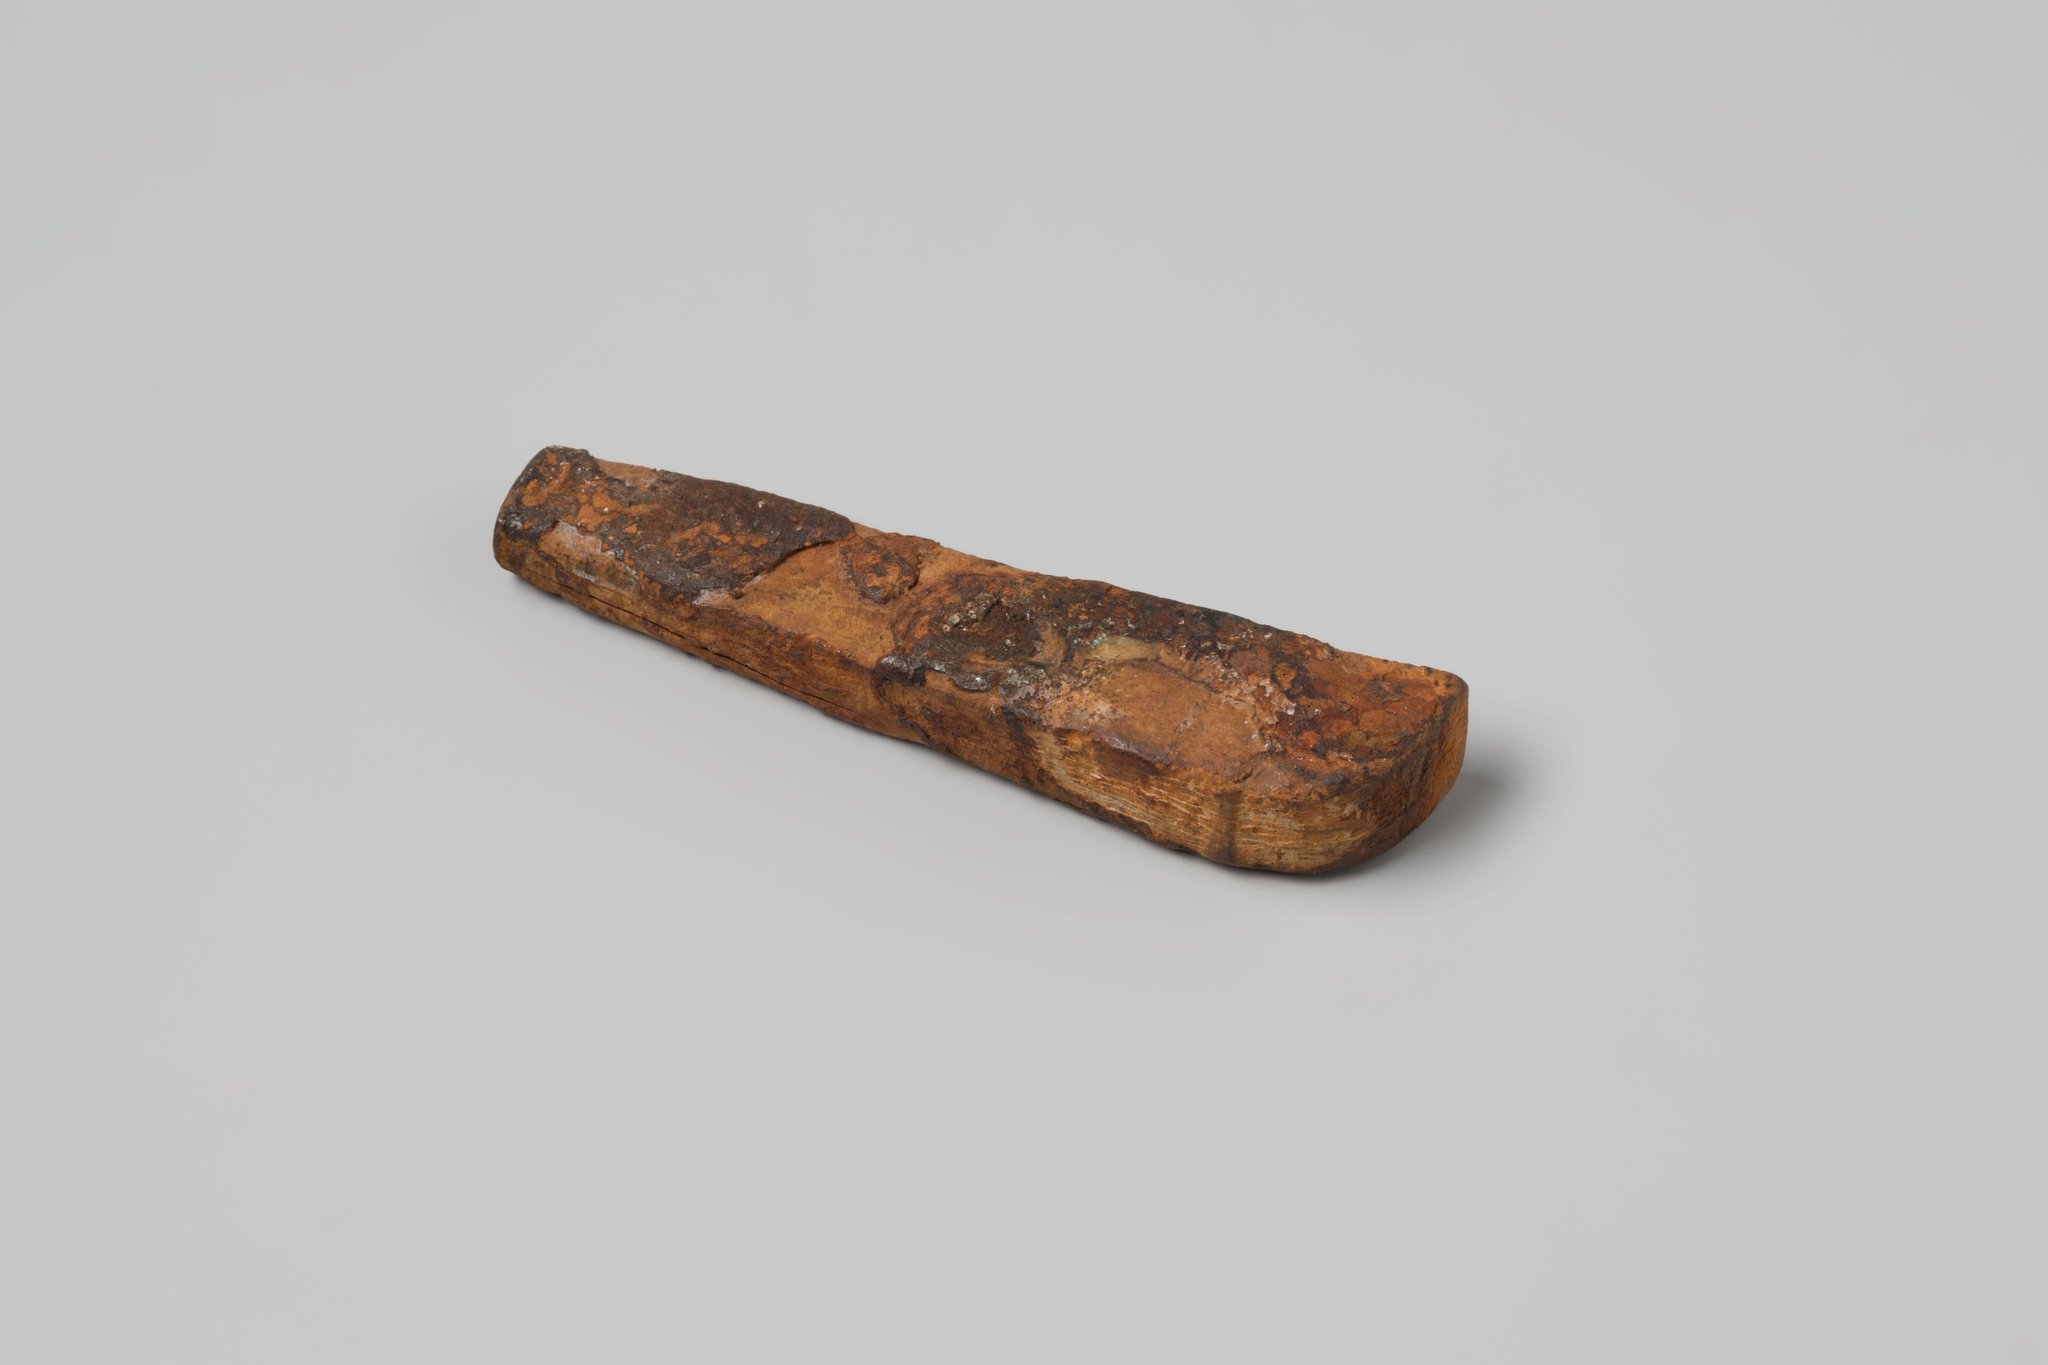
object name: knife handle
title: Messenheft uit het wrak van de Oost-Indiëvaarder Hollandia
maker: Anonymous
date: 1700-1743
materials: bone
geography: netherlands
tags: verenigde oostindische compagnie, hollandia (schip), annet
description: Knive, handle pistol-grip-shaped; flat, rectangular in section, tapering.